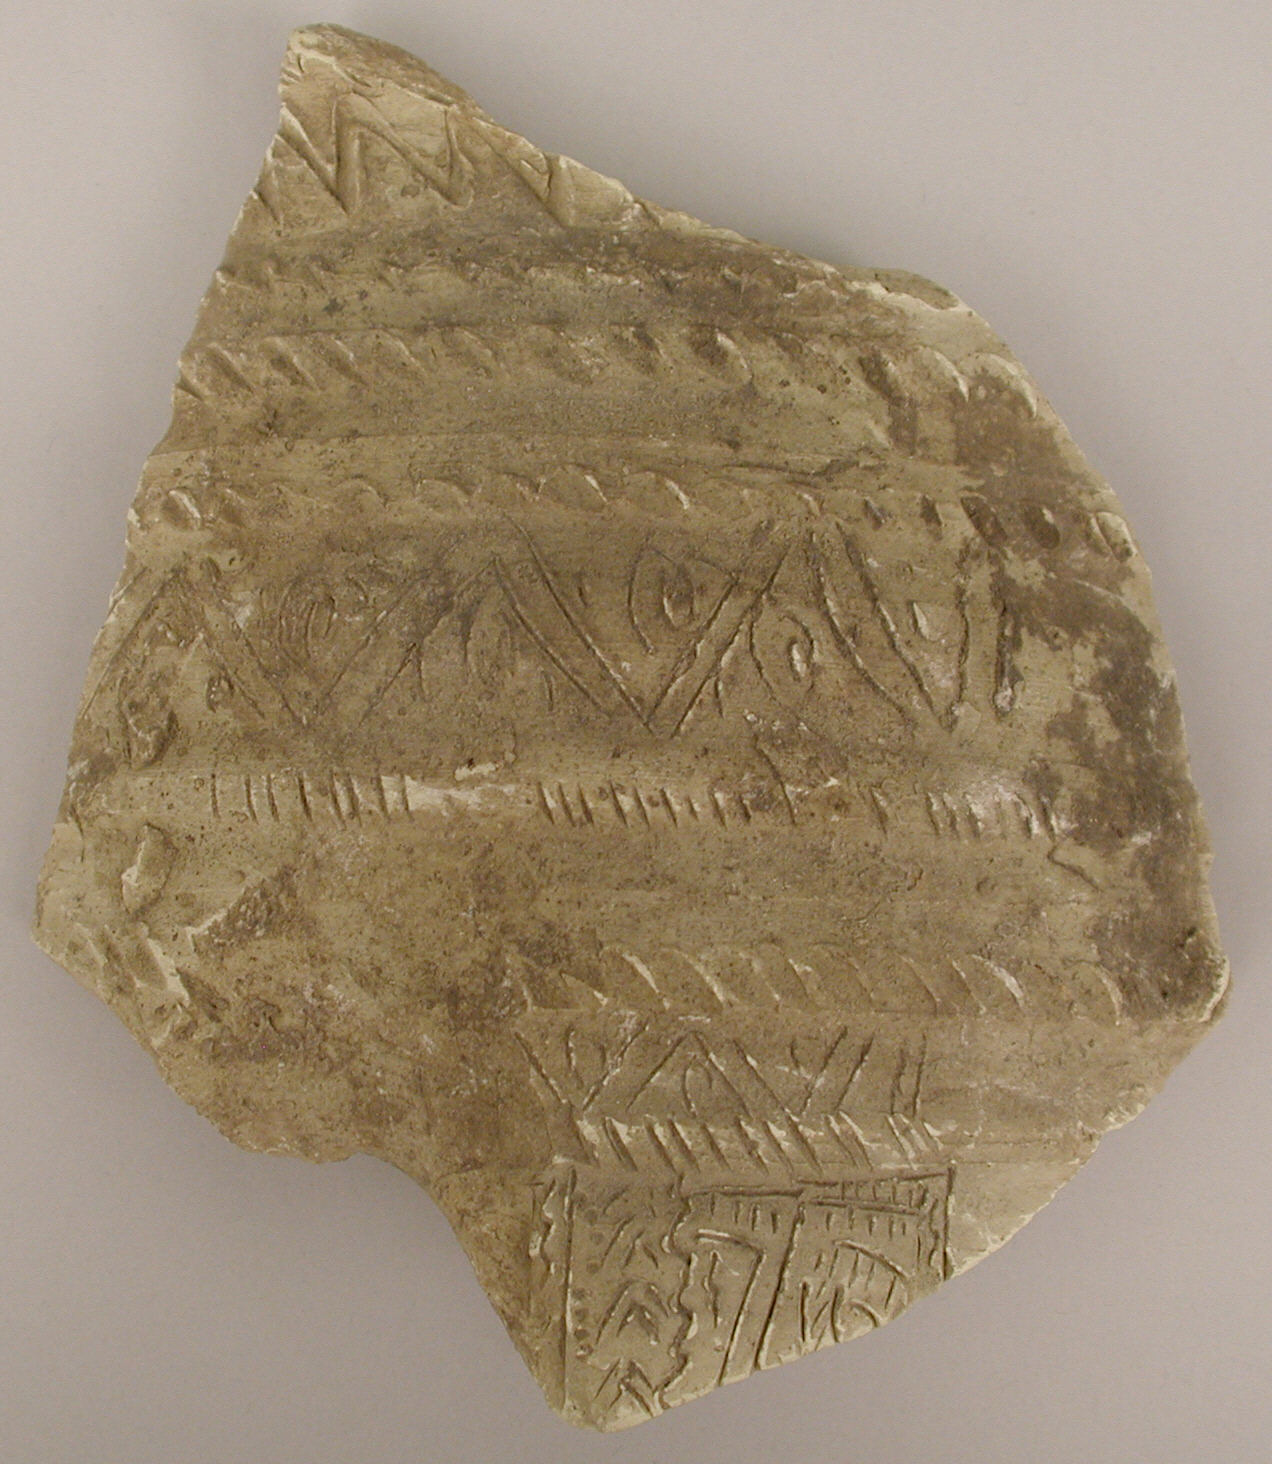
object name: fragment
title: Ceramic Fragment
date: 701-900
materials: earthenware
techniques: incising, molding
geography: iraq